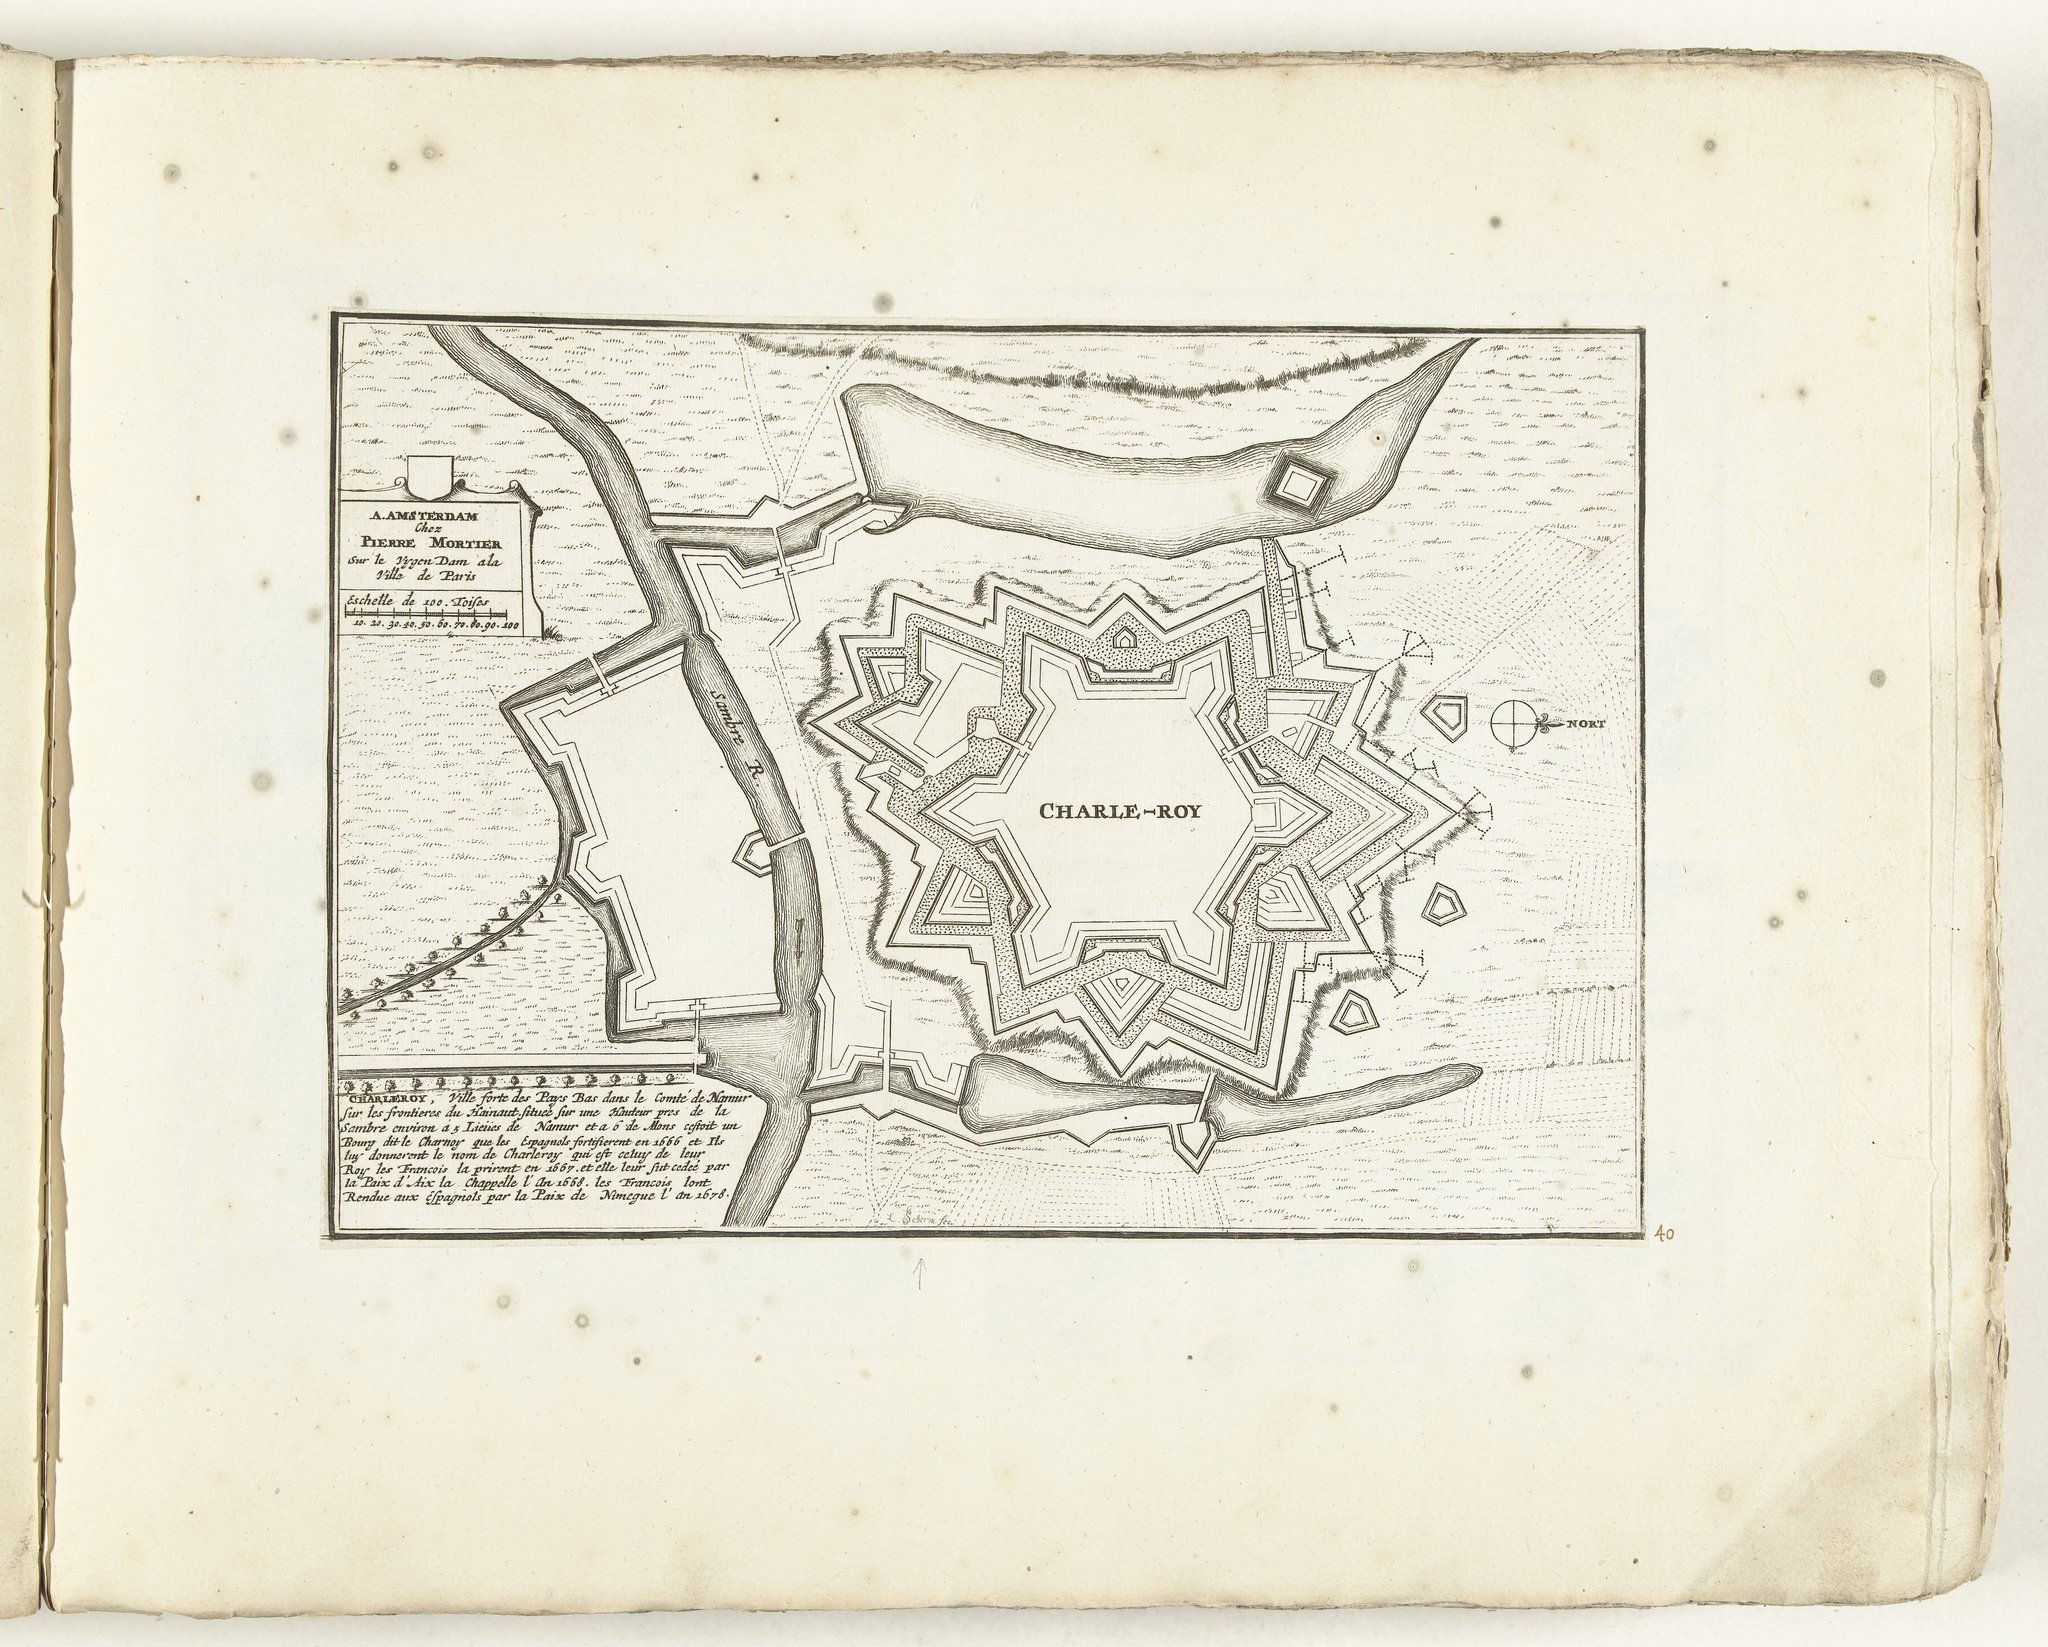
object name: map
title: Charleroy, Ville forte des Pays Bas dans le Comté de Namur (...)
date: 1702-1703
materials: paper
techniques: etching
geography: amsterdam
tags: fortress, maps of cities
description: Plattegrond van de verdedigingswerken om de stad Charleroi. Plaat nr. 40 in het prentwerk bestaande in totaal uit 276 genummerde platen van vermaarde sterke steden en vestingen in het kader van de Spaanse Successieoorlog. Voor het merendeel zijn deze platen gekopieerd naar de anonieme Franse platen: in Les forces de l'Europe en in: Le theatre de la guerre, dans les Pays-Bas, beide oorspronkelijk uitgegeven door Nicolas de Fer te Parijs (1693-1697) in het kader van de Negenjarige Oorlog. Titel en opschriften in de plaat in het Frans. Het blad uitgeknipt en opgeplakt.